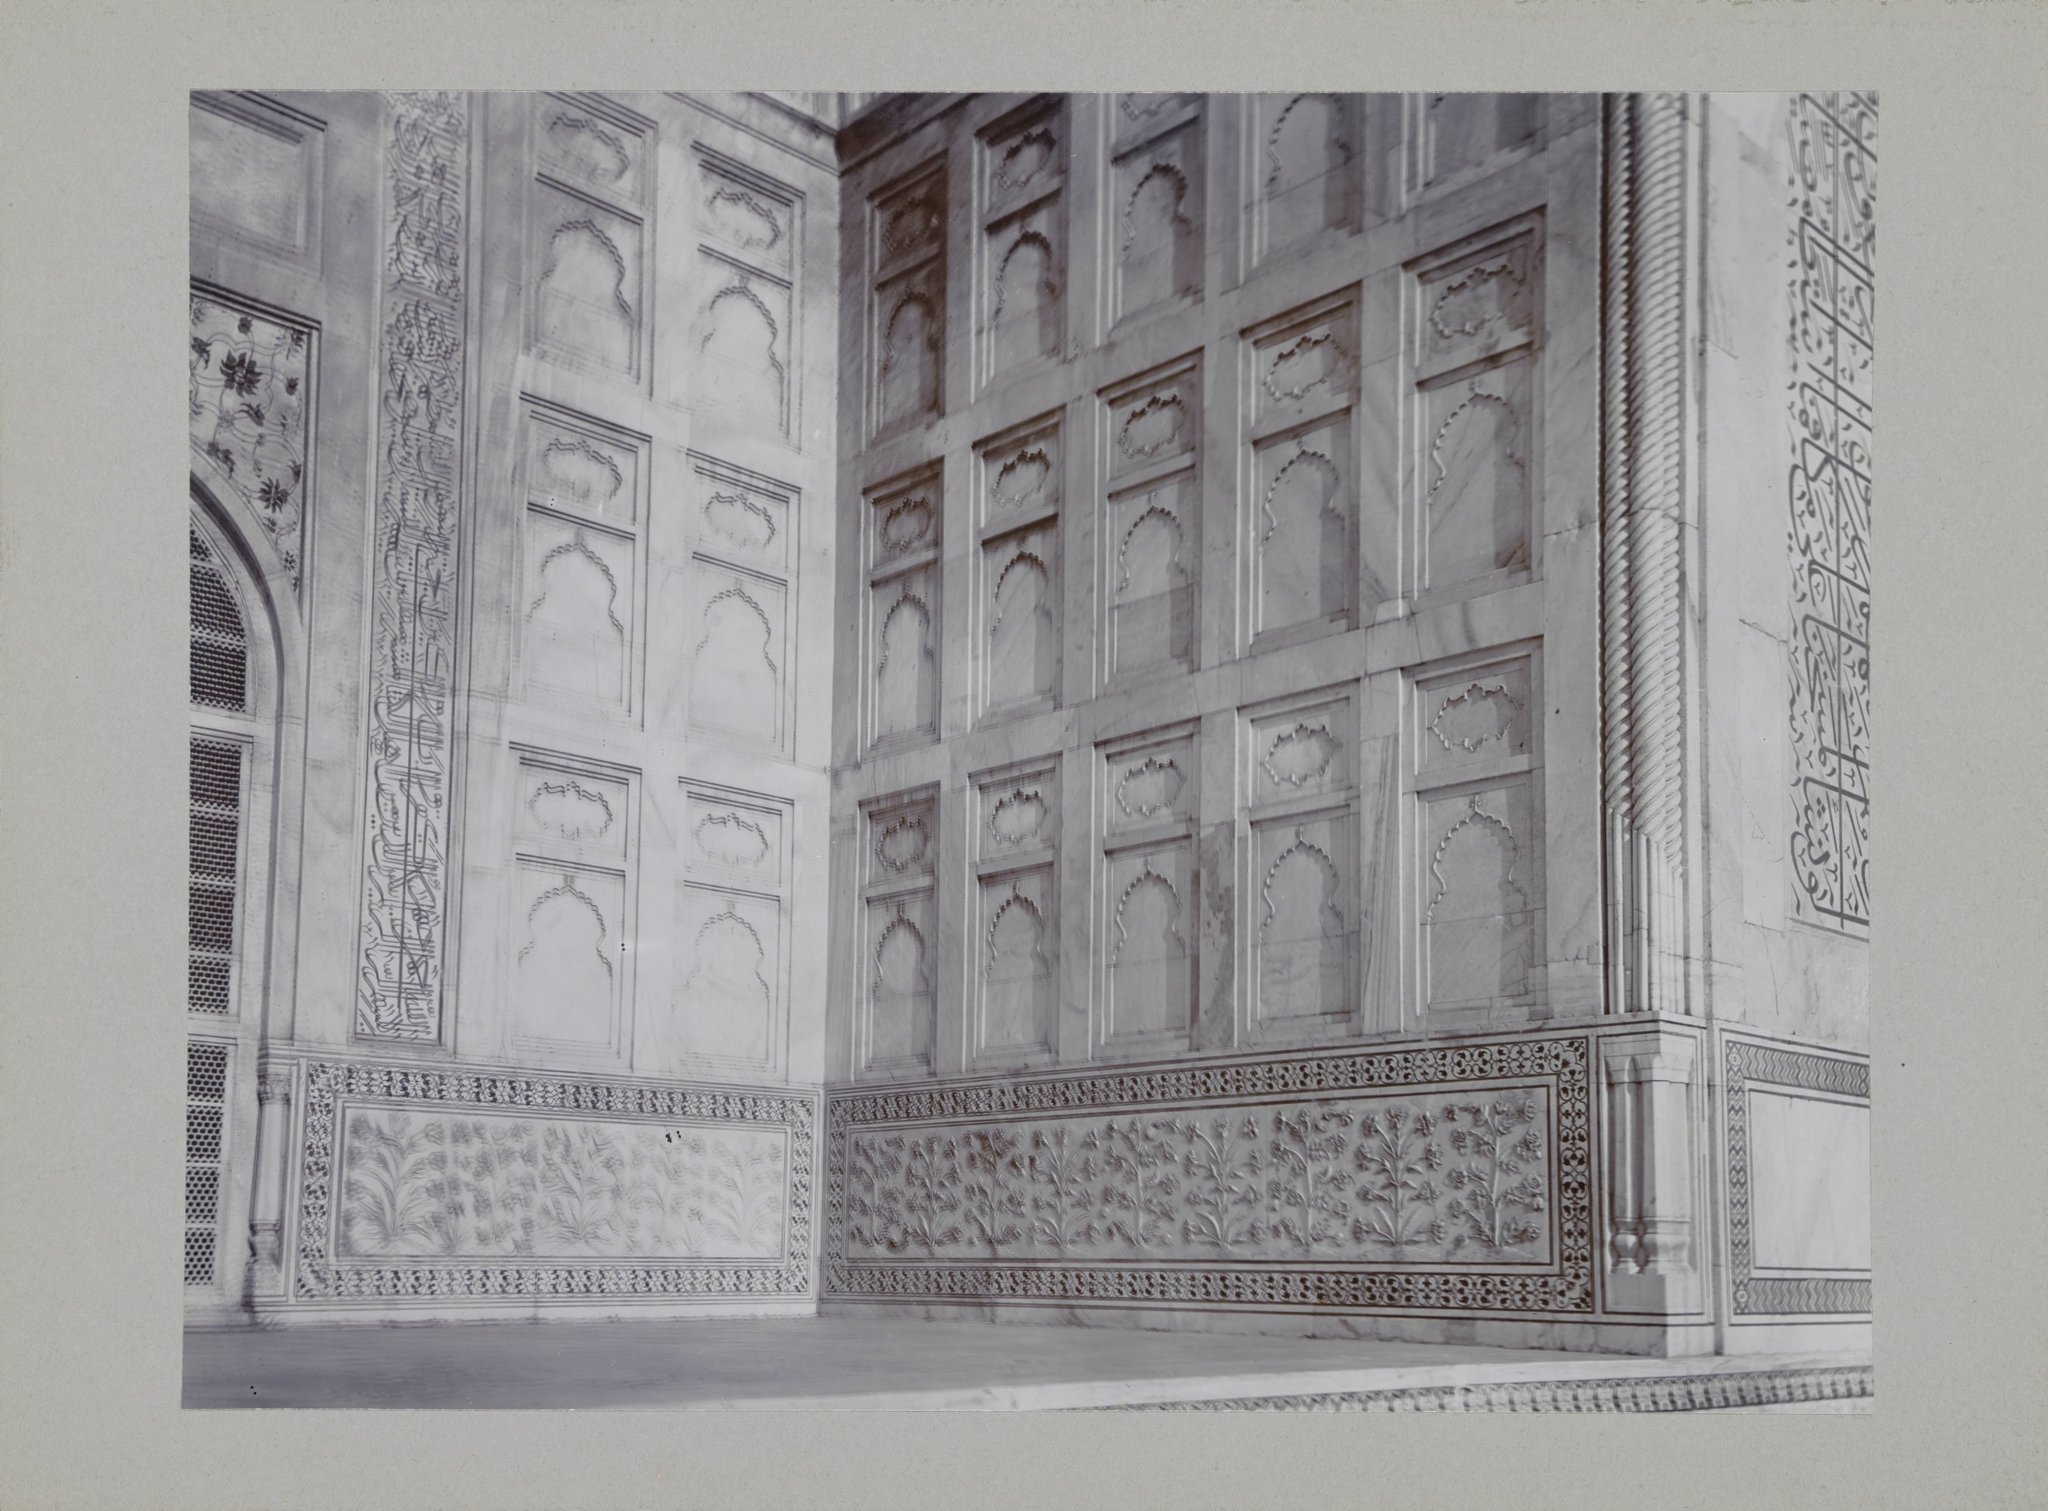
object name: photograph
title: Wall near the door of the Taj Mahal, Agra, Uttar Pradesh, India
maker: Anonymous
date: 1895-1915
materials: cardboard, paper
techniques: gelatin silver print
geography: agra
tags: agra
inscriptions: annotation: ‘57. Taj. Mahal’